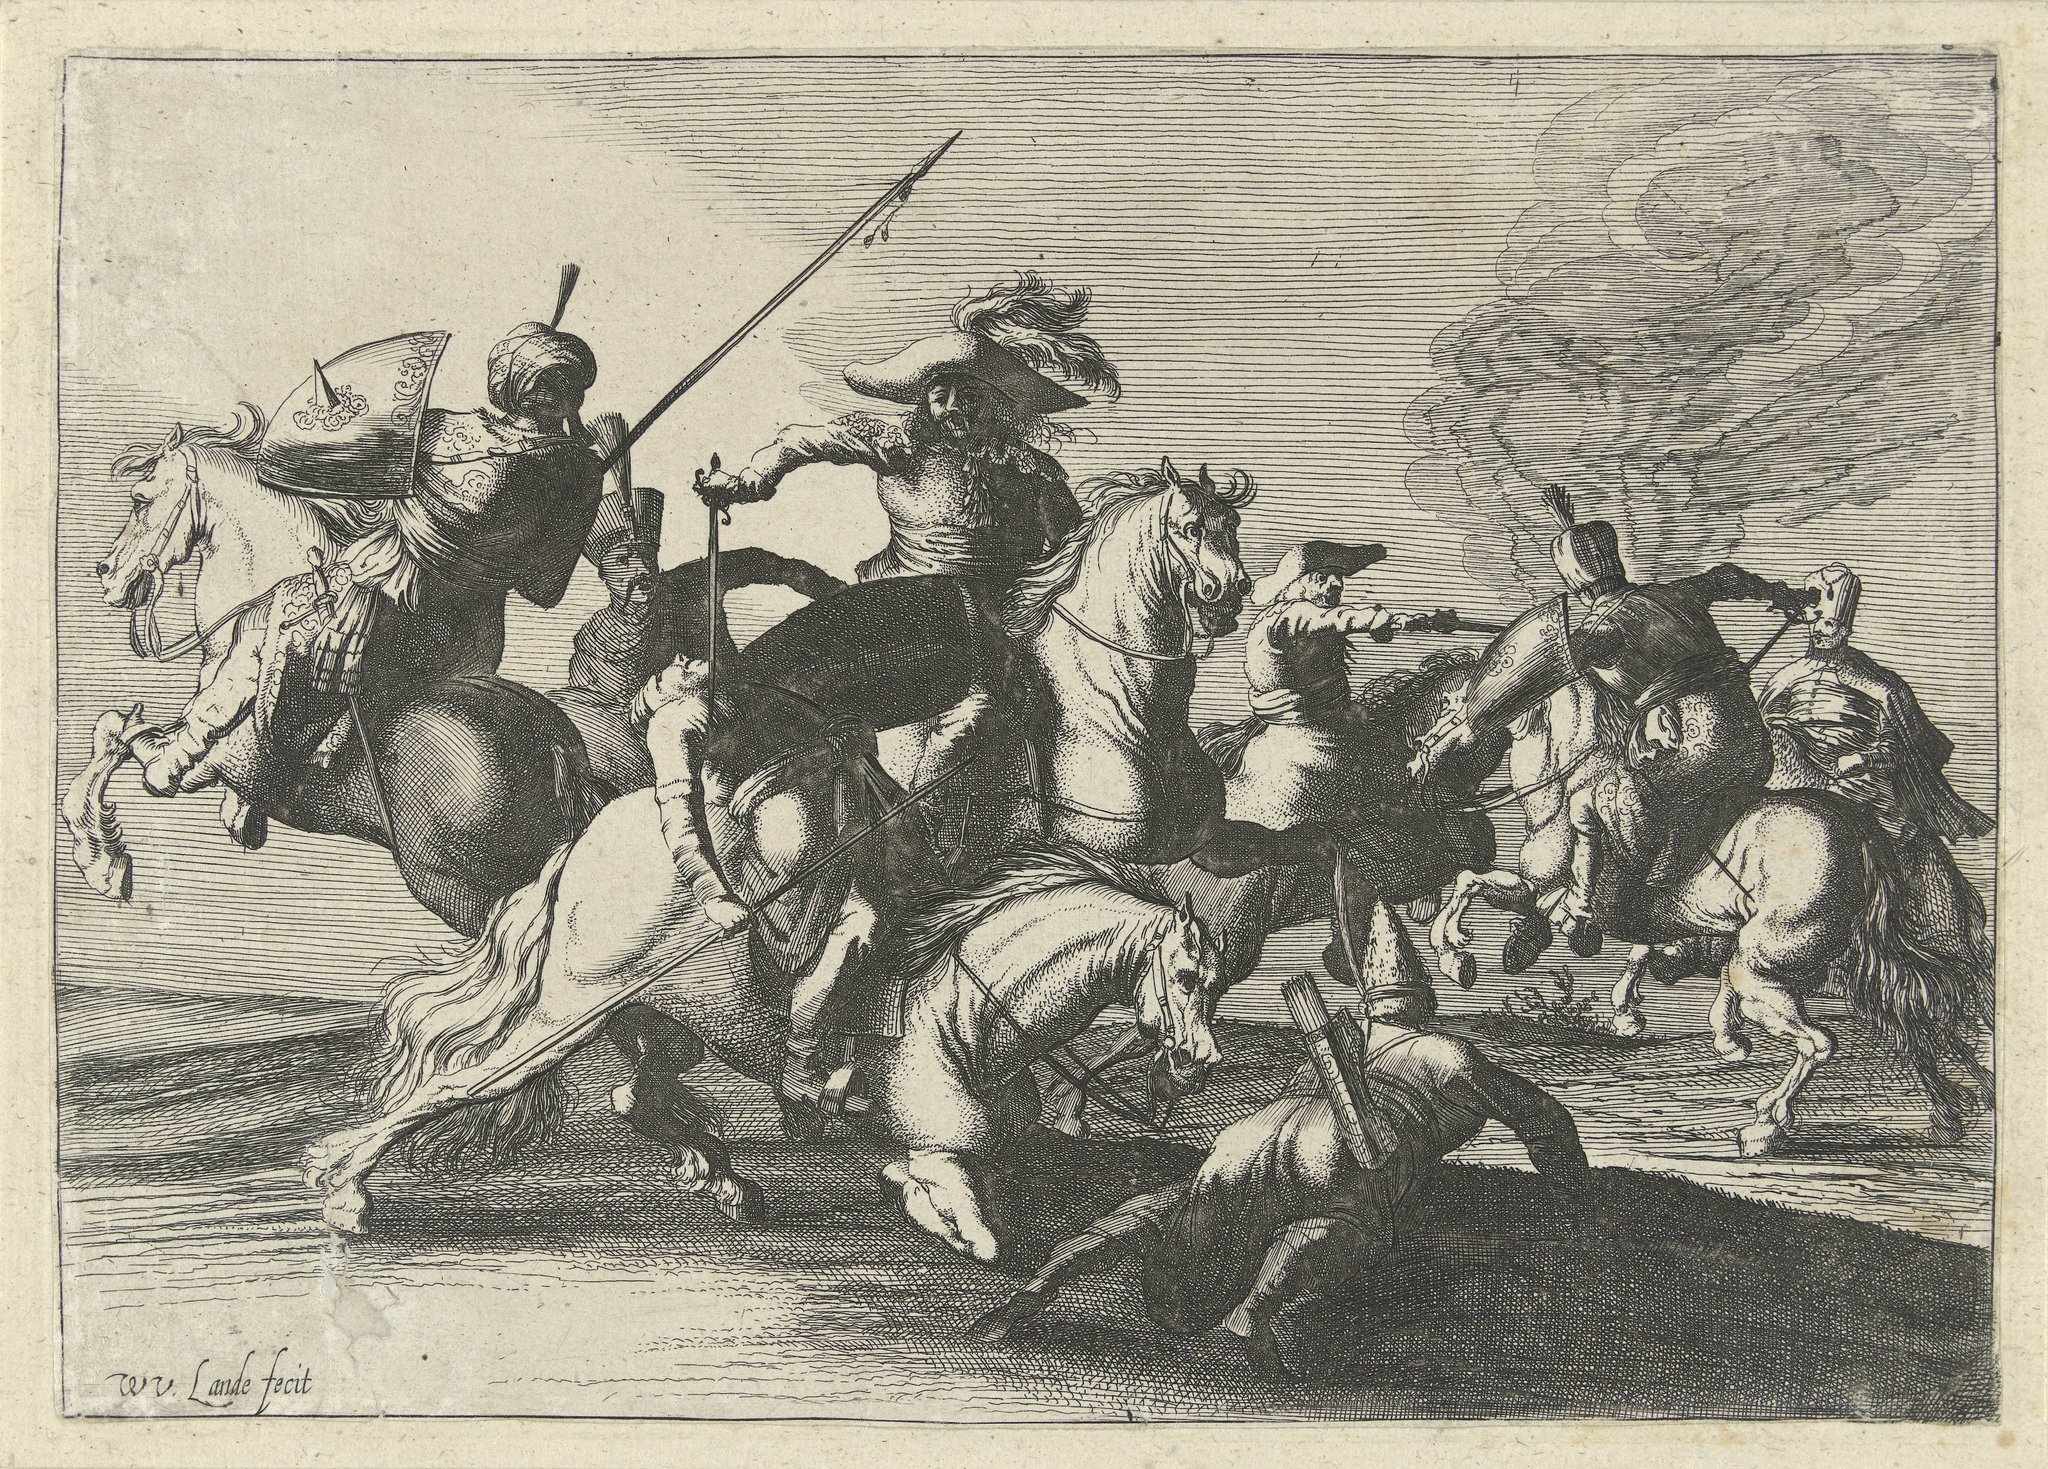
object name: print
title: Ruitergevechten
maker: willem van de lande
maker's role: print maker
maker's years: 1610-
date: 1635-1650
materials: paper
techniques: etching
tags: riding a horse, ass, or mule; rider, horseman, battle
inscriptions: collector's mark: Lugt 240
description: Slagveldscène waarin een ruiter in Westerse kledij te paard een Turkse tegenstander neersabelt. De prent maakt deel uit van een zesdelige serie prenten met ruitergevechten.